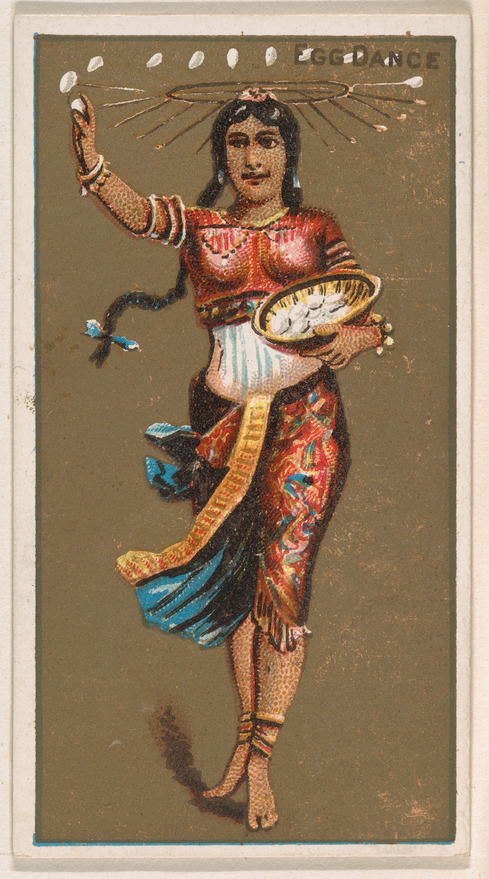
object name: print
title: Egg Dance, from National Dances (N225, Type 1) issued by Kinney Bros.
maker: kinney brothers tobacco company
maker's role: publisher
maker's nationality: american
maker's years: 1869-2011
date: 1889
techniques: color lithograph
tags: dance,women,dancers